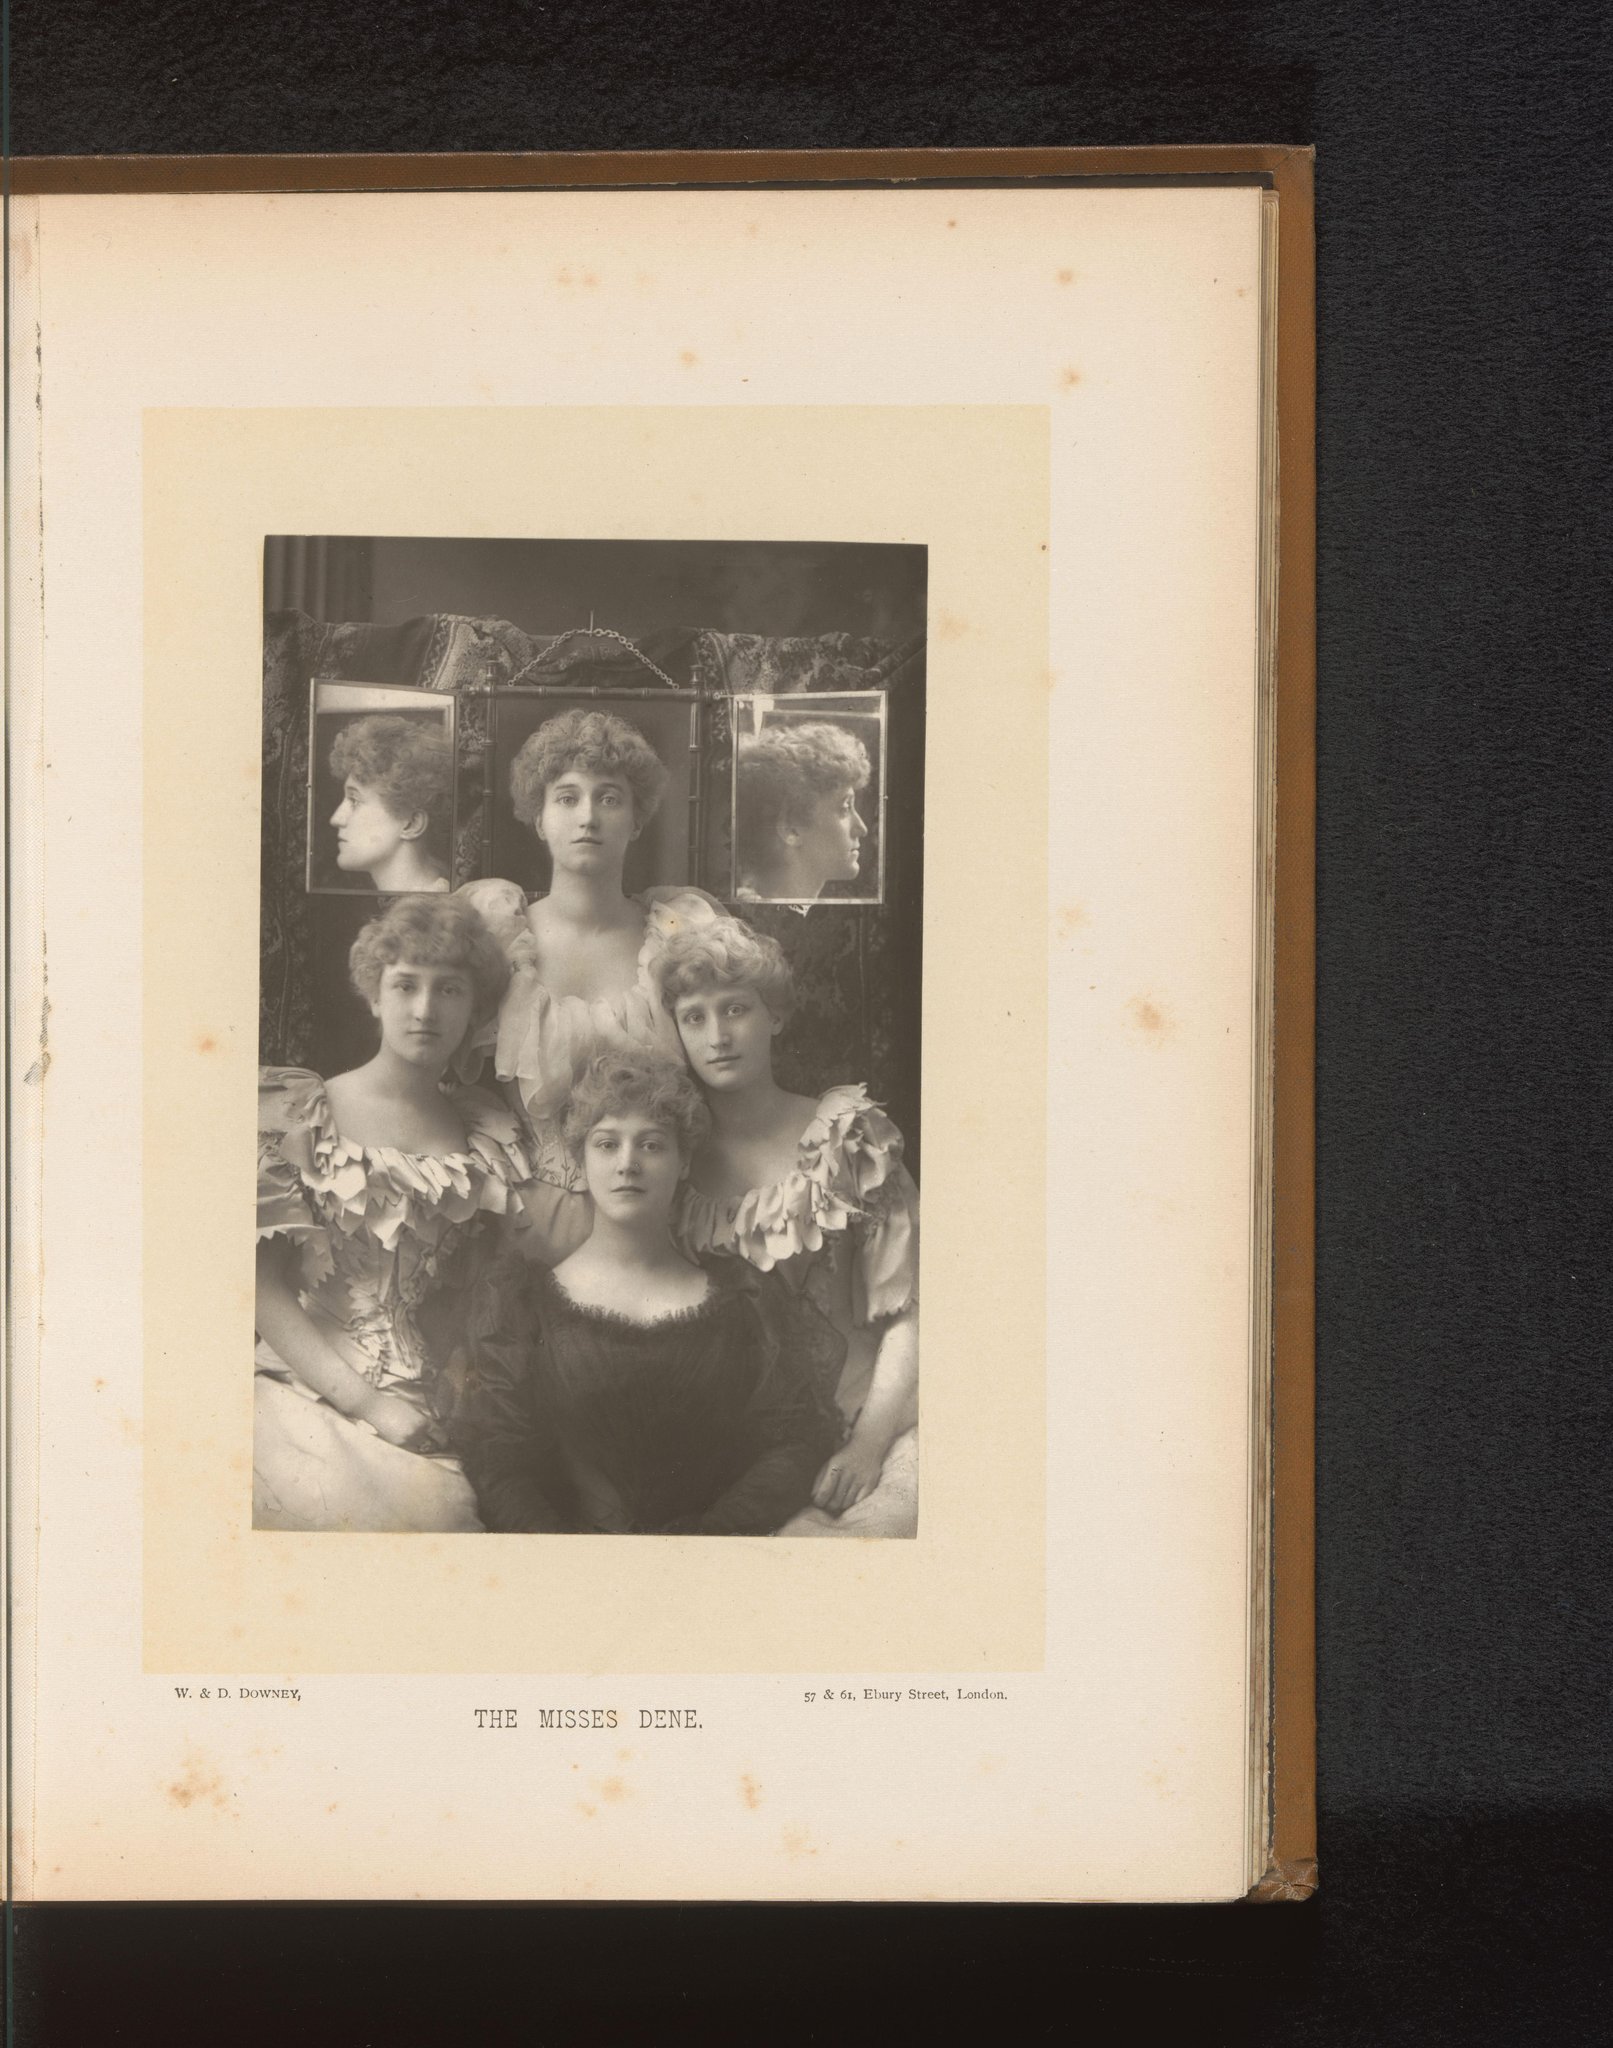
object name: page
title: The Misses Dene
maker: Anonymous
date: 1883-1893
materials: paper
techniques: woodburytype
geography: london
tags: portrait of actor, actress, sisters (second degree family relationships)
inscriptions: inscription: ‘57 & 61, Elbury Street, London.’